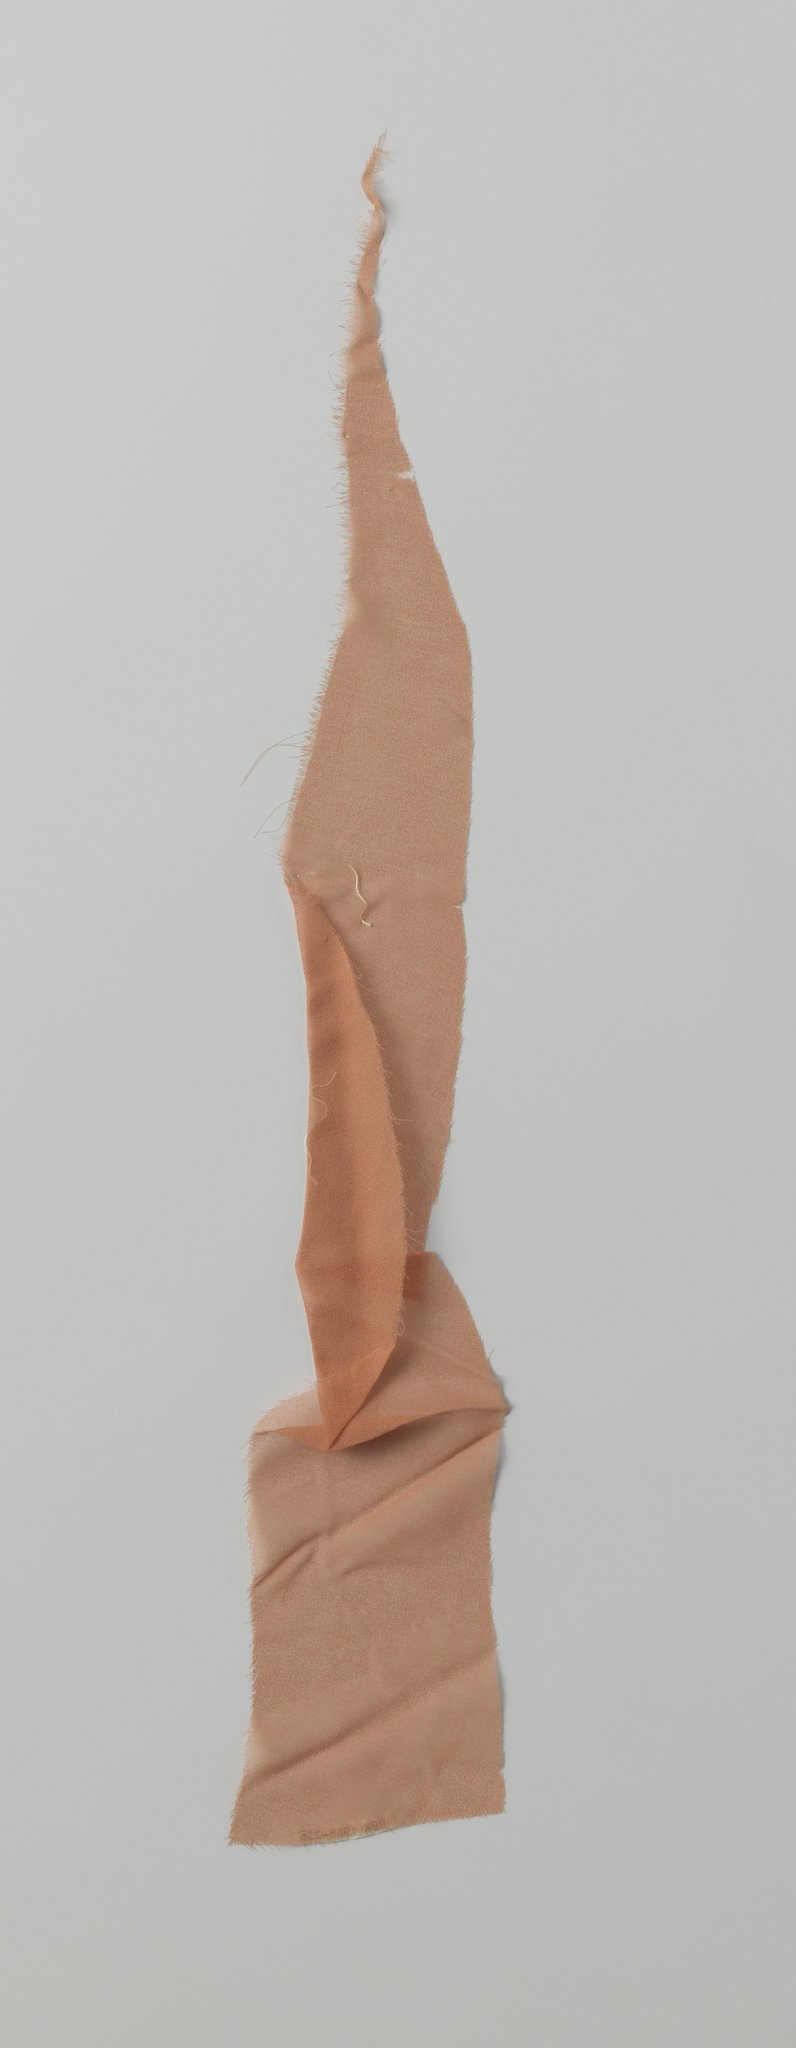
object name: silk textile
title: Fragment oranje zijdeweefsel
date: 1400-1950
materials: silk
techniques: weave